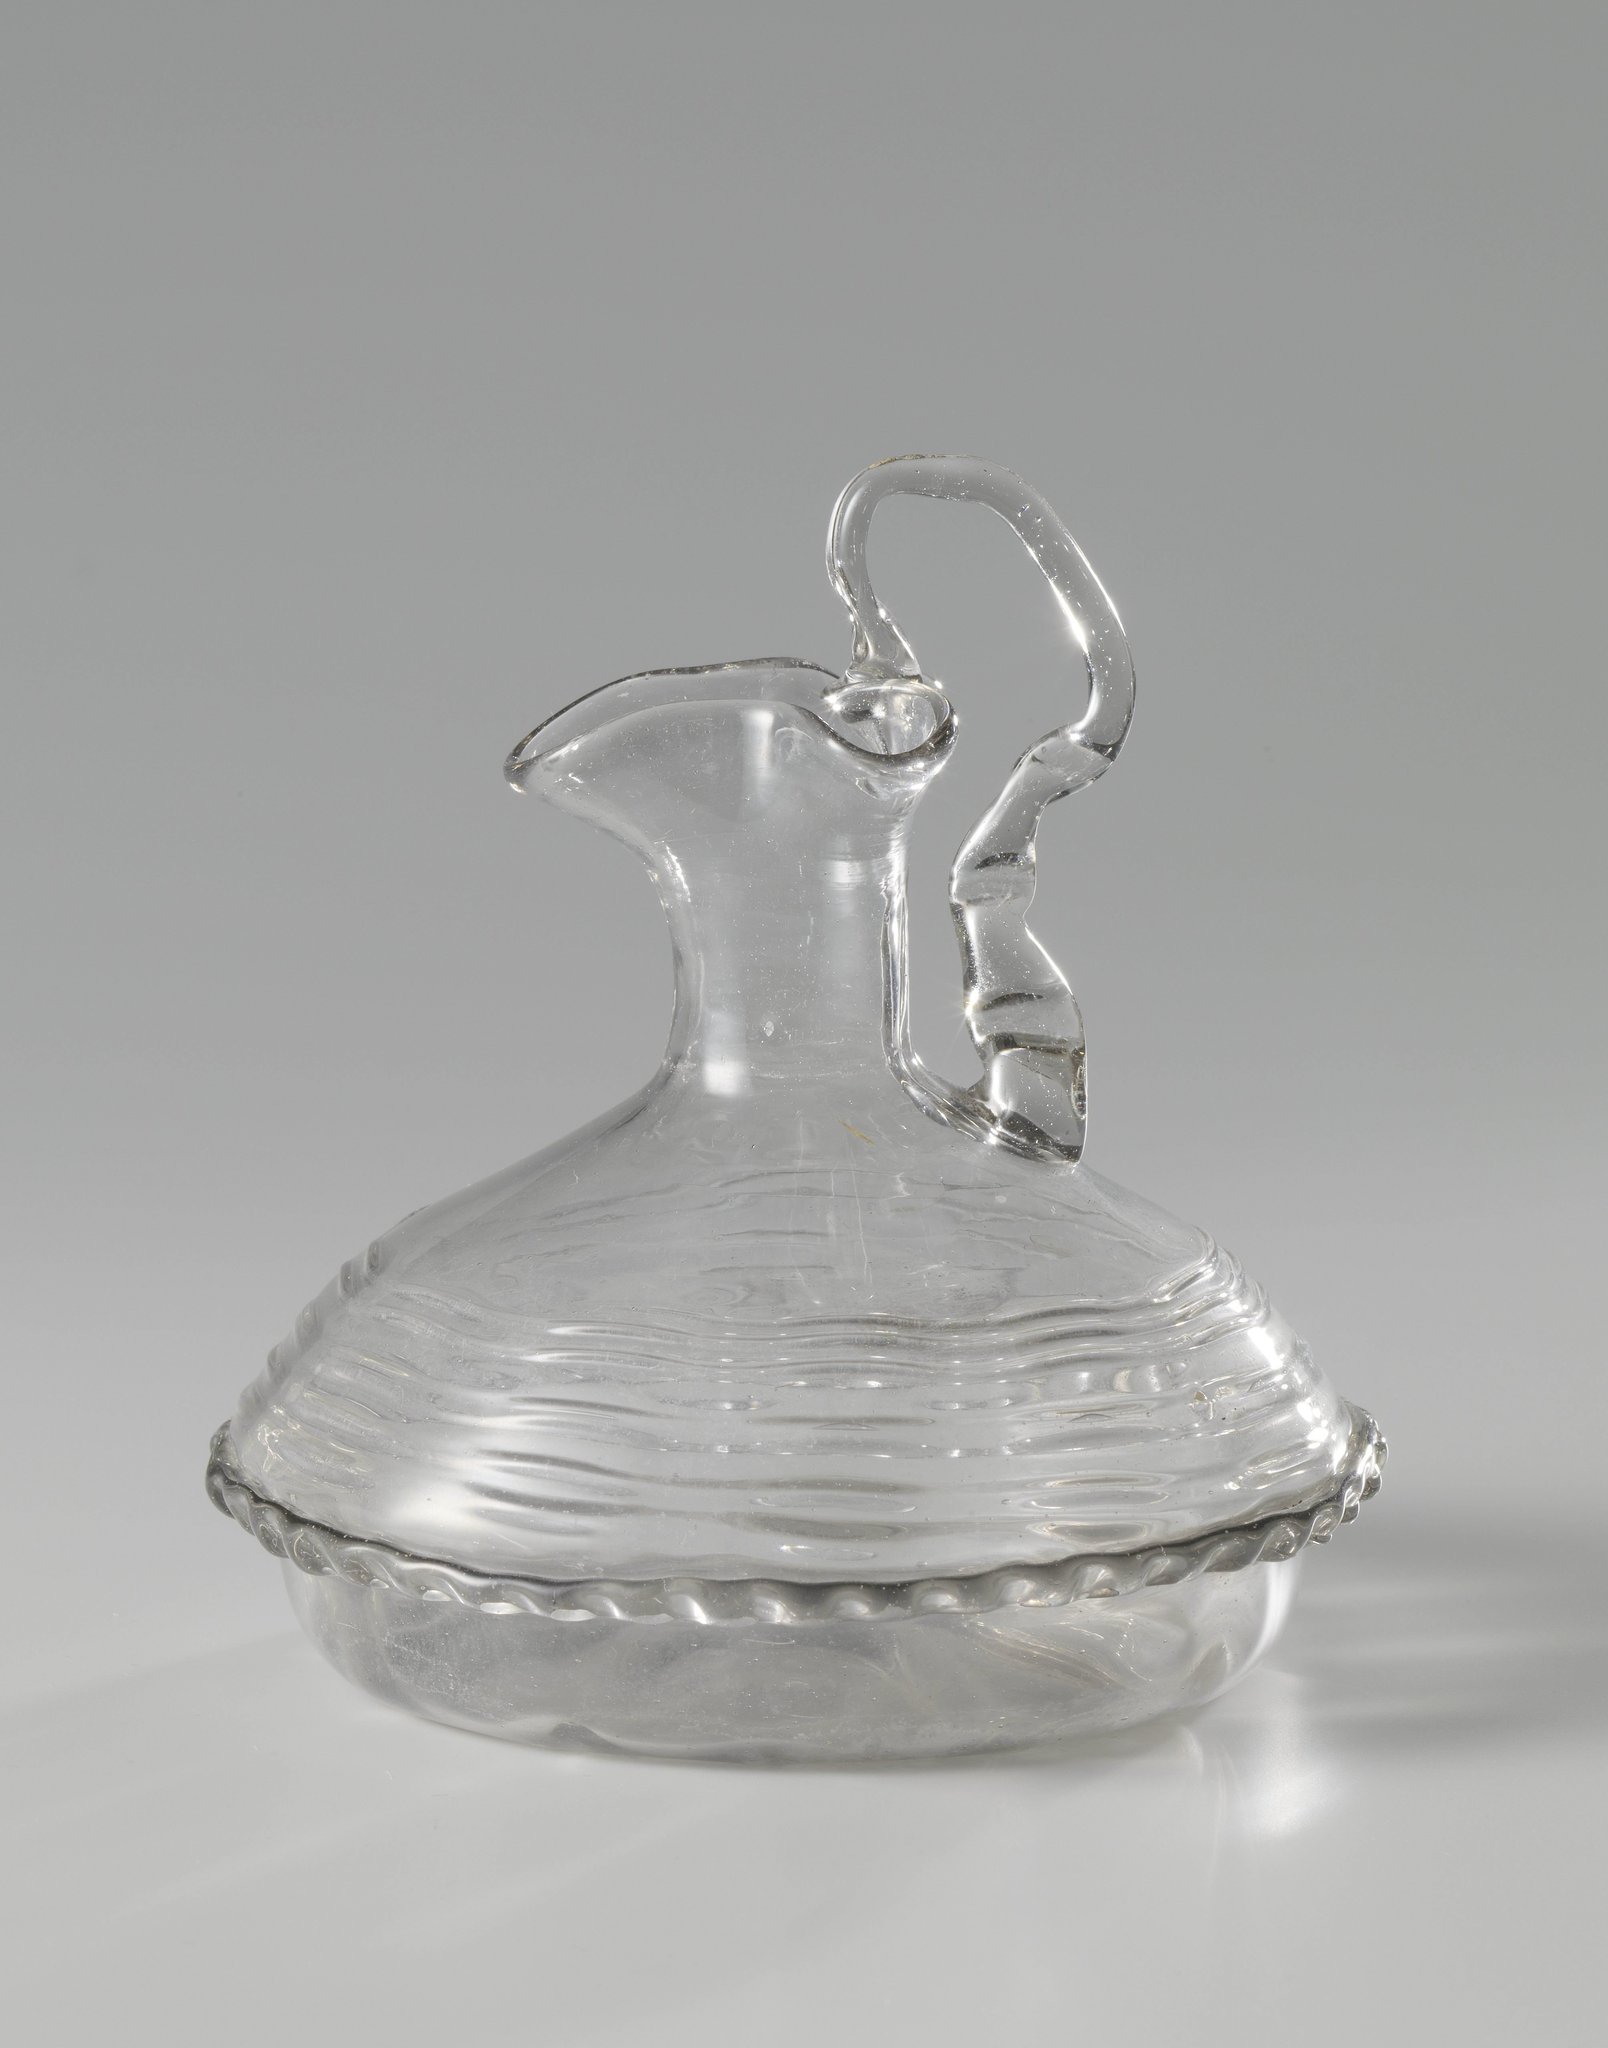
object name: ewer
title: Kan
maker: Anonymous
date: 1550-1600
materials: glass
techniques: glassblowing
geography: venice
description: Kan met geribde, licht ingestoken bodem. Gedrukt, bolvormig lichaam met een geribde draad en opgesmolten gladde draden. De hals loopt uit in een driepasvormige mond. Onregelmatig gevormd hoog opgaand oor.